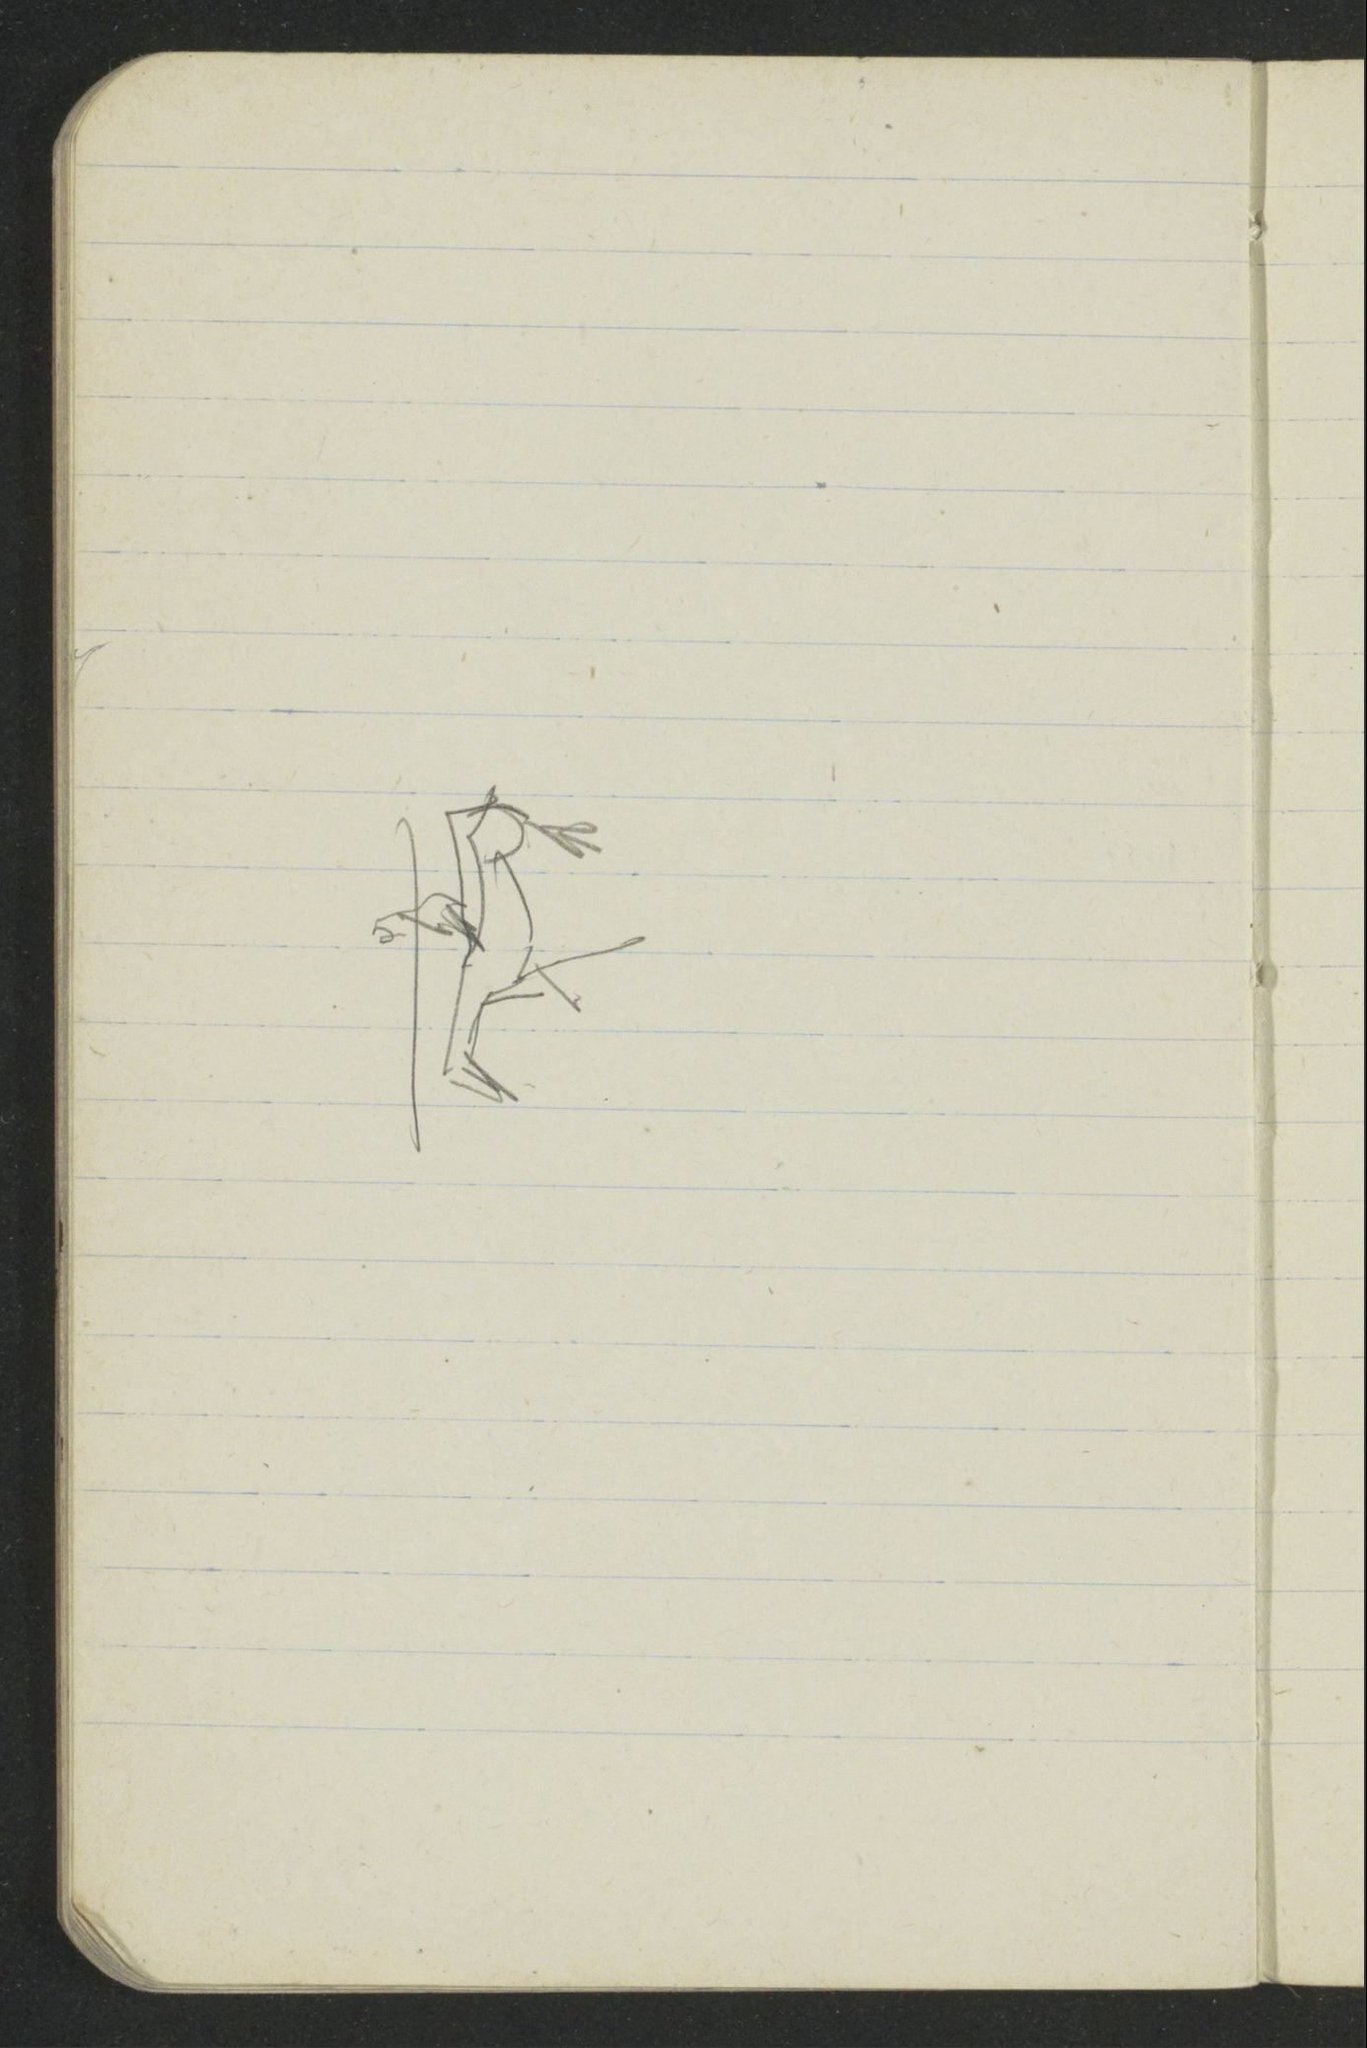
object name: sketchbook leaf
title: Ruiter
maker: isaac israels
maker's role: draughtsman, painter, print maker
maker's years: 1865-1934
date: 1875-1934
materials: pencil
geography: the hague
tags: riding a horse, ass, or mule; rider, horseman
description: Pagina 34 uit schetsboek XL met 40 pagina's.